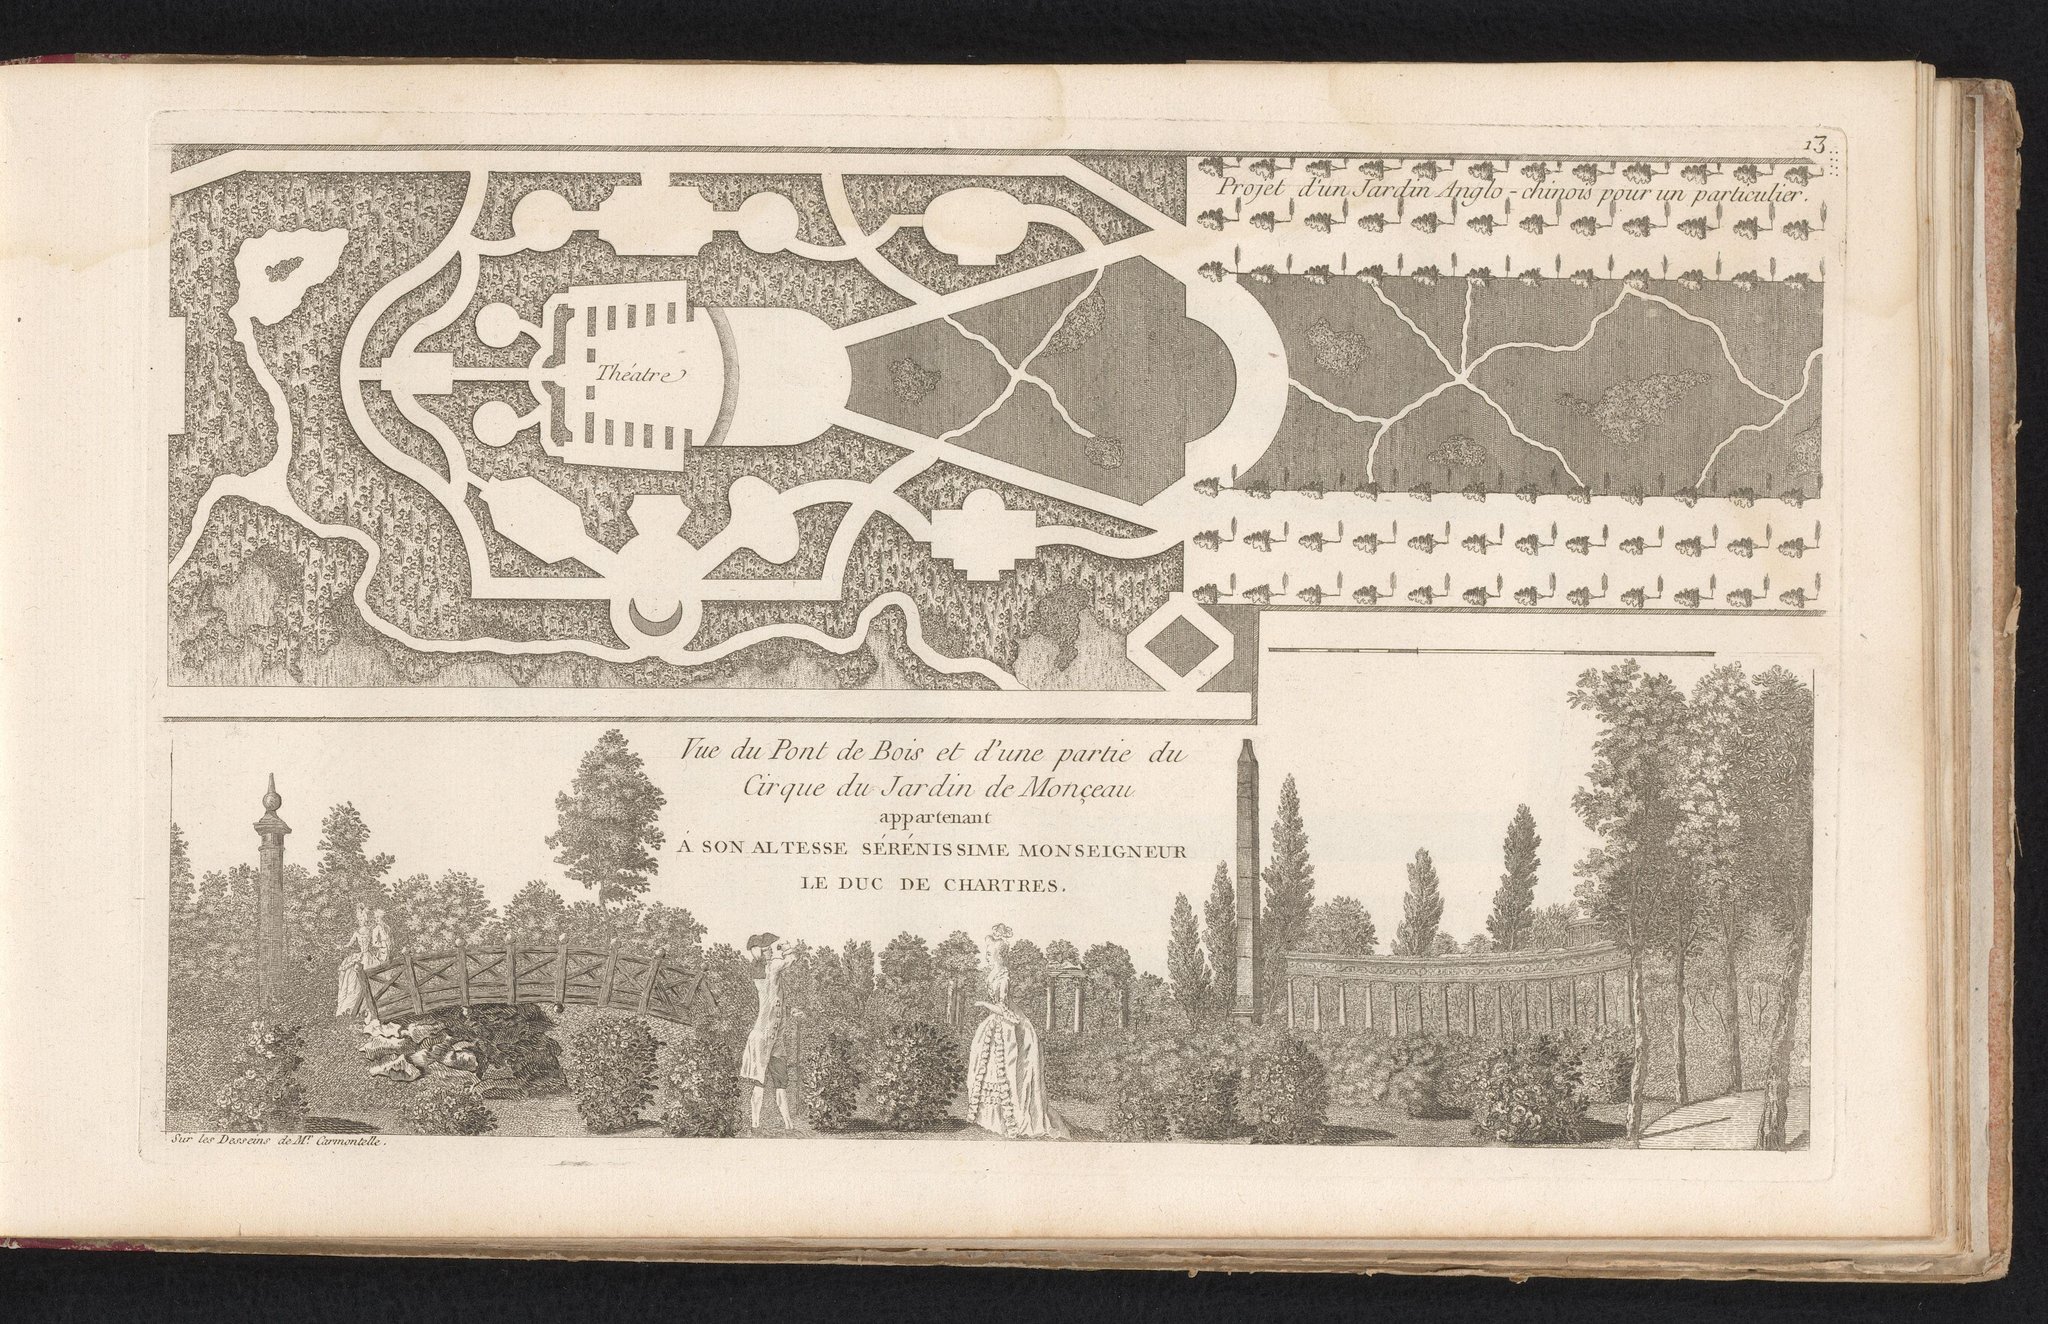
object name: print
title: Landschapstuinen in Chinees-Engelse stijl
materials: paper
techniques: engraving, etching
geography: paris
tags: plan, map of garden, garden buildings, bridge, paris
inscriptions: collector's mark: Lugt 2760, collector's mark: Lugt 2228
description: De serie 'Jardins anglo-chinois à la mode' verscheen in totaal in 21 zogeheten 'cahiers' (afleveringen). De huidige prent komt uit het achtste 'cahier'. Het Rijksmuseum Amsterdam bezit drie banden met daarin in totaal zes 'cahiers' van deze reeks. In de documentatie wordt verwezen naar een in de bibliotheek van het Rijksmuseum Amsterdam aanwezige facsimile van het complete werk.